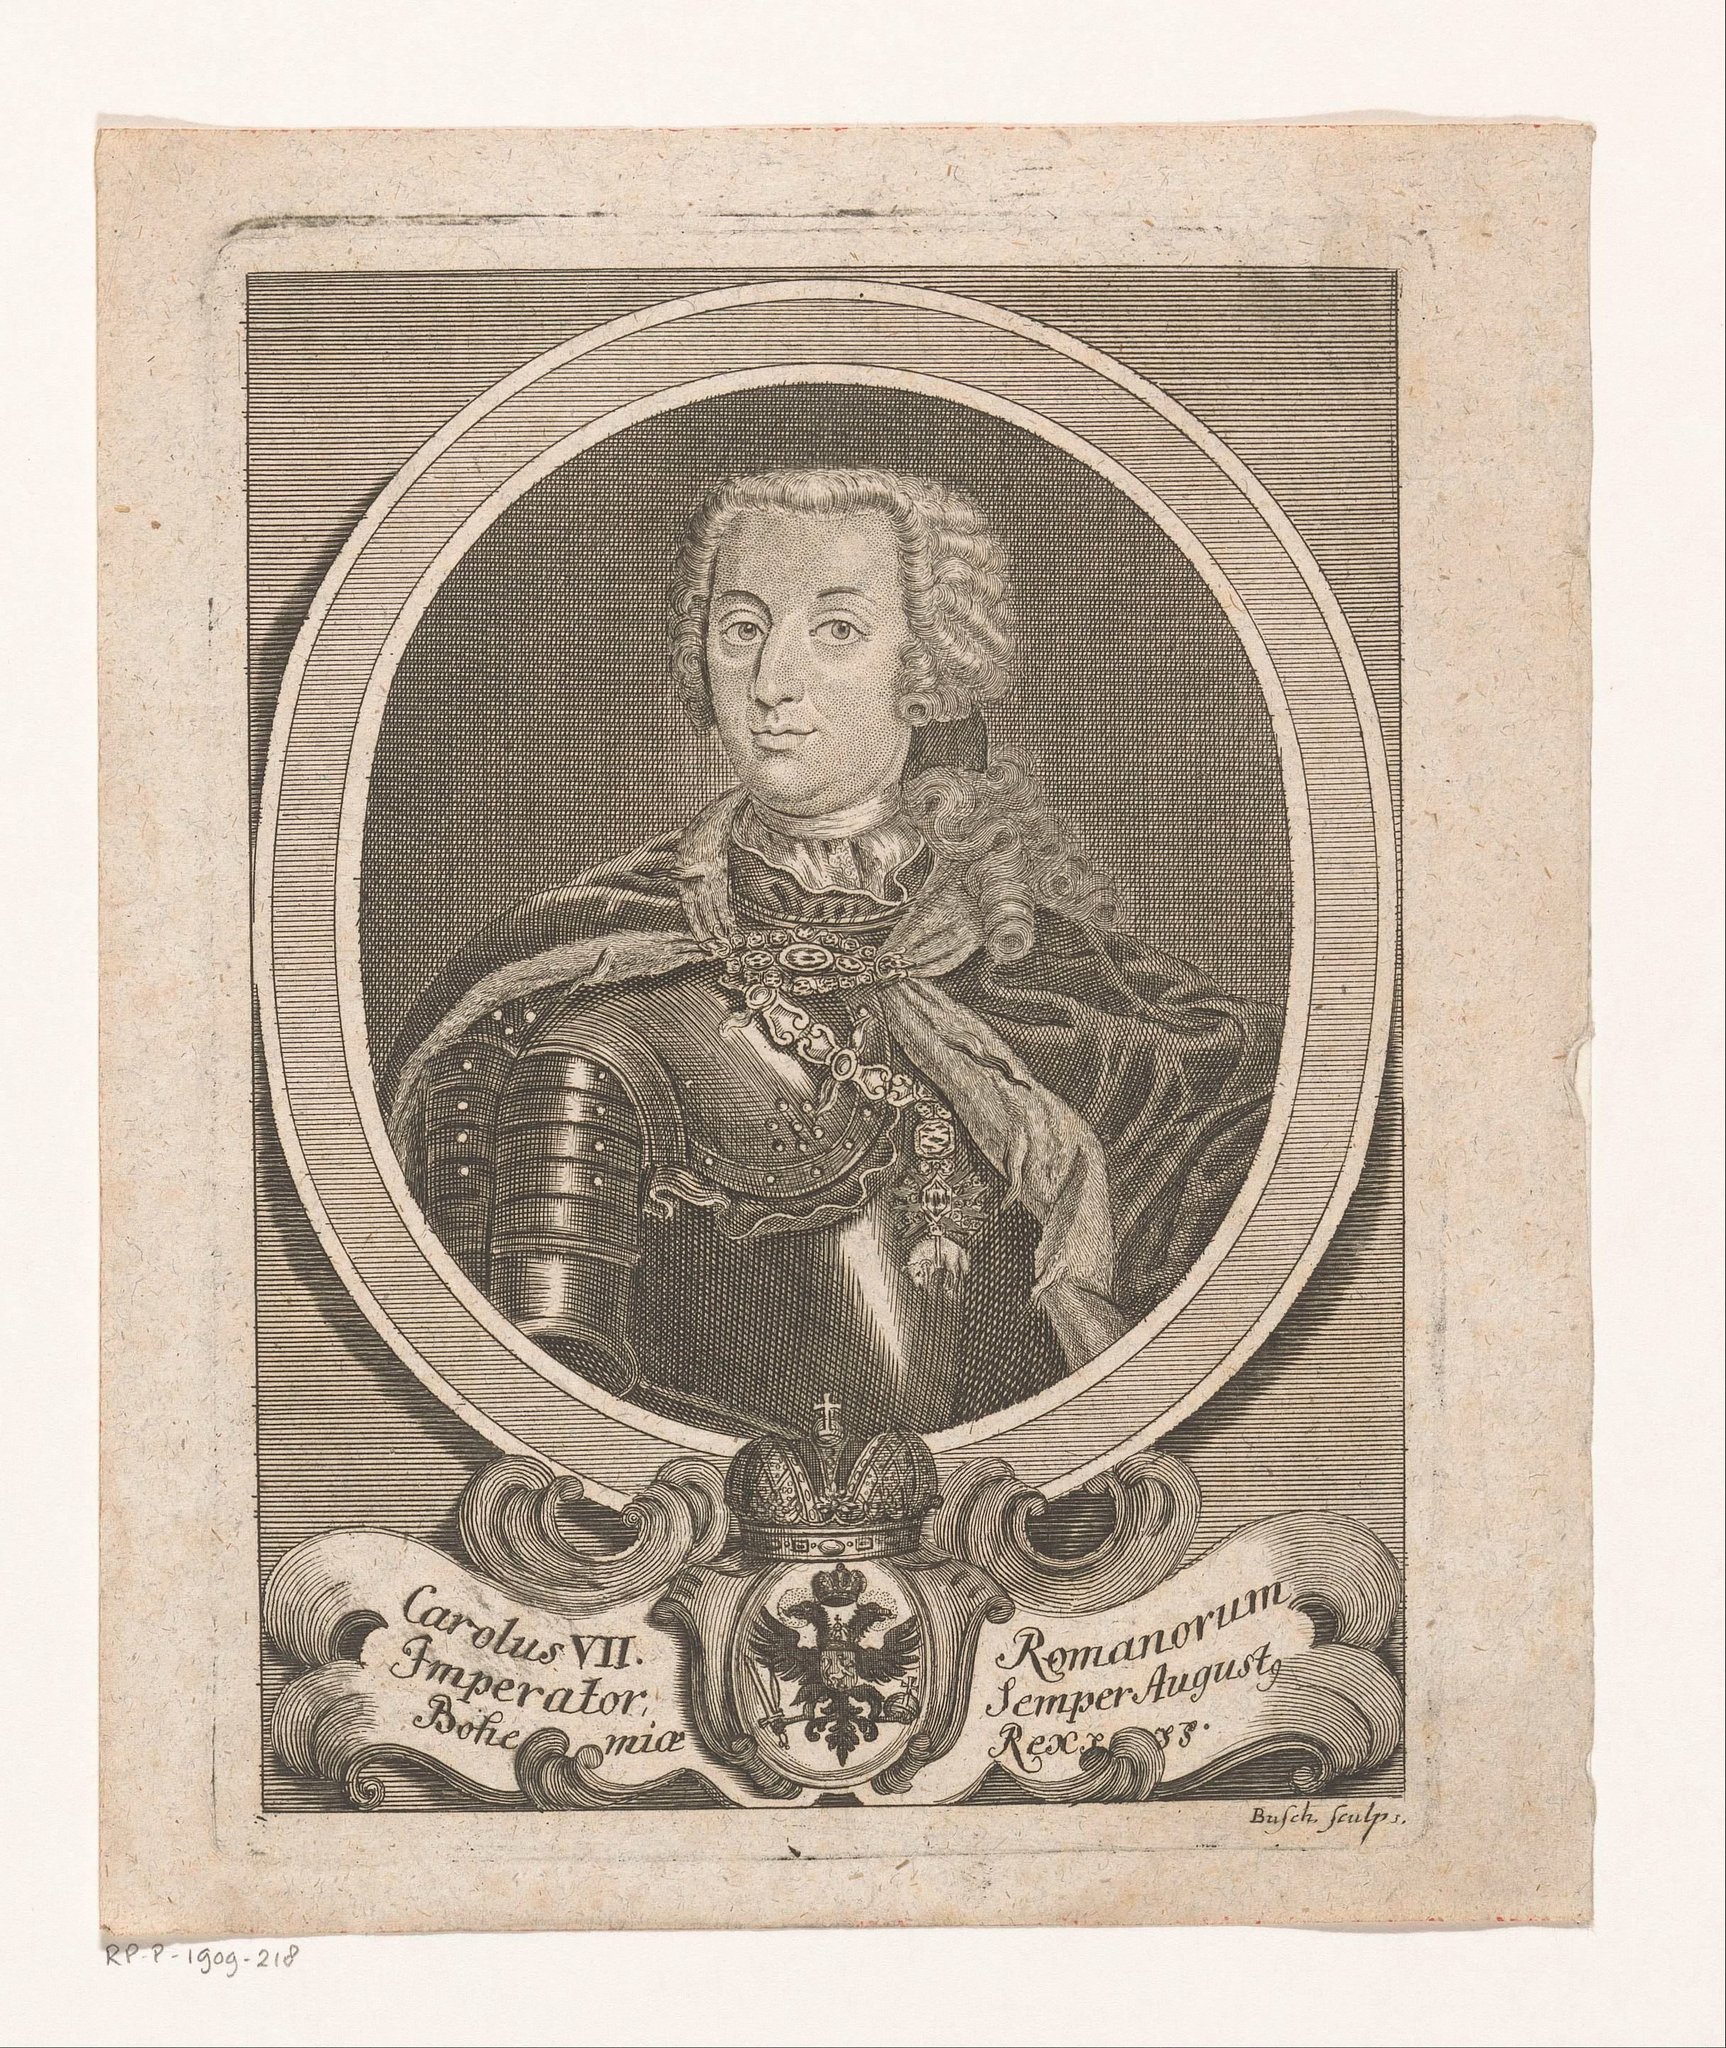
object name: print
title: Portret van Karel VII Albrecht, Rooms-Duits keizer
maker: georg paul busch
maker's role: print maker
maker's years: -1756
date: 1742-1756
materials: paper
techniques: engraving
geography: berlin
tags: brussels, karel vii albrecht (duits keizer), armour, historical persons, knighthood order of the golden fleece - insignia of a knighthood order, e.g.: badge, chain (with name of order), armorial bearing, heraldry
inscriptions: collector's mark: Lugt 2228